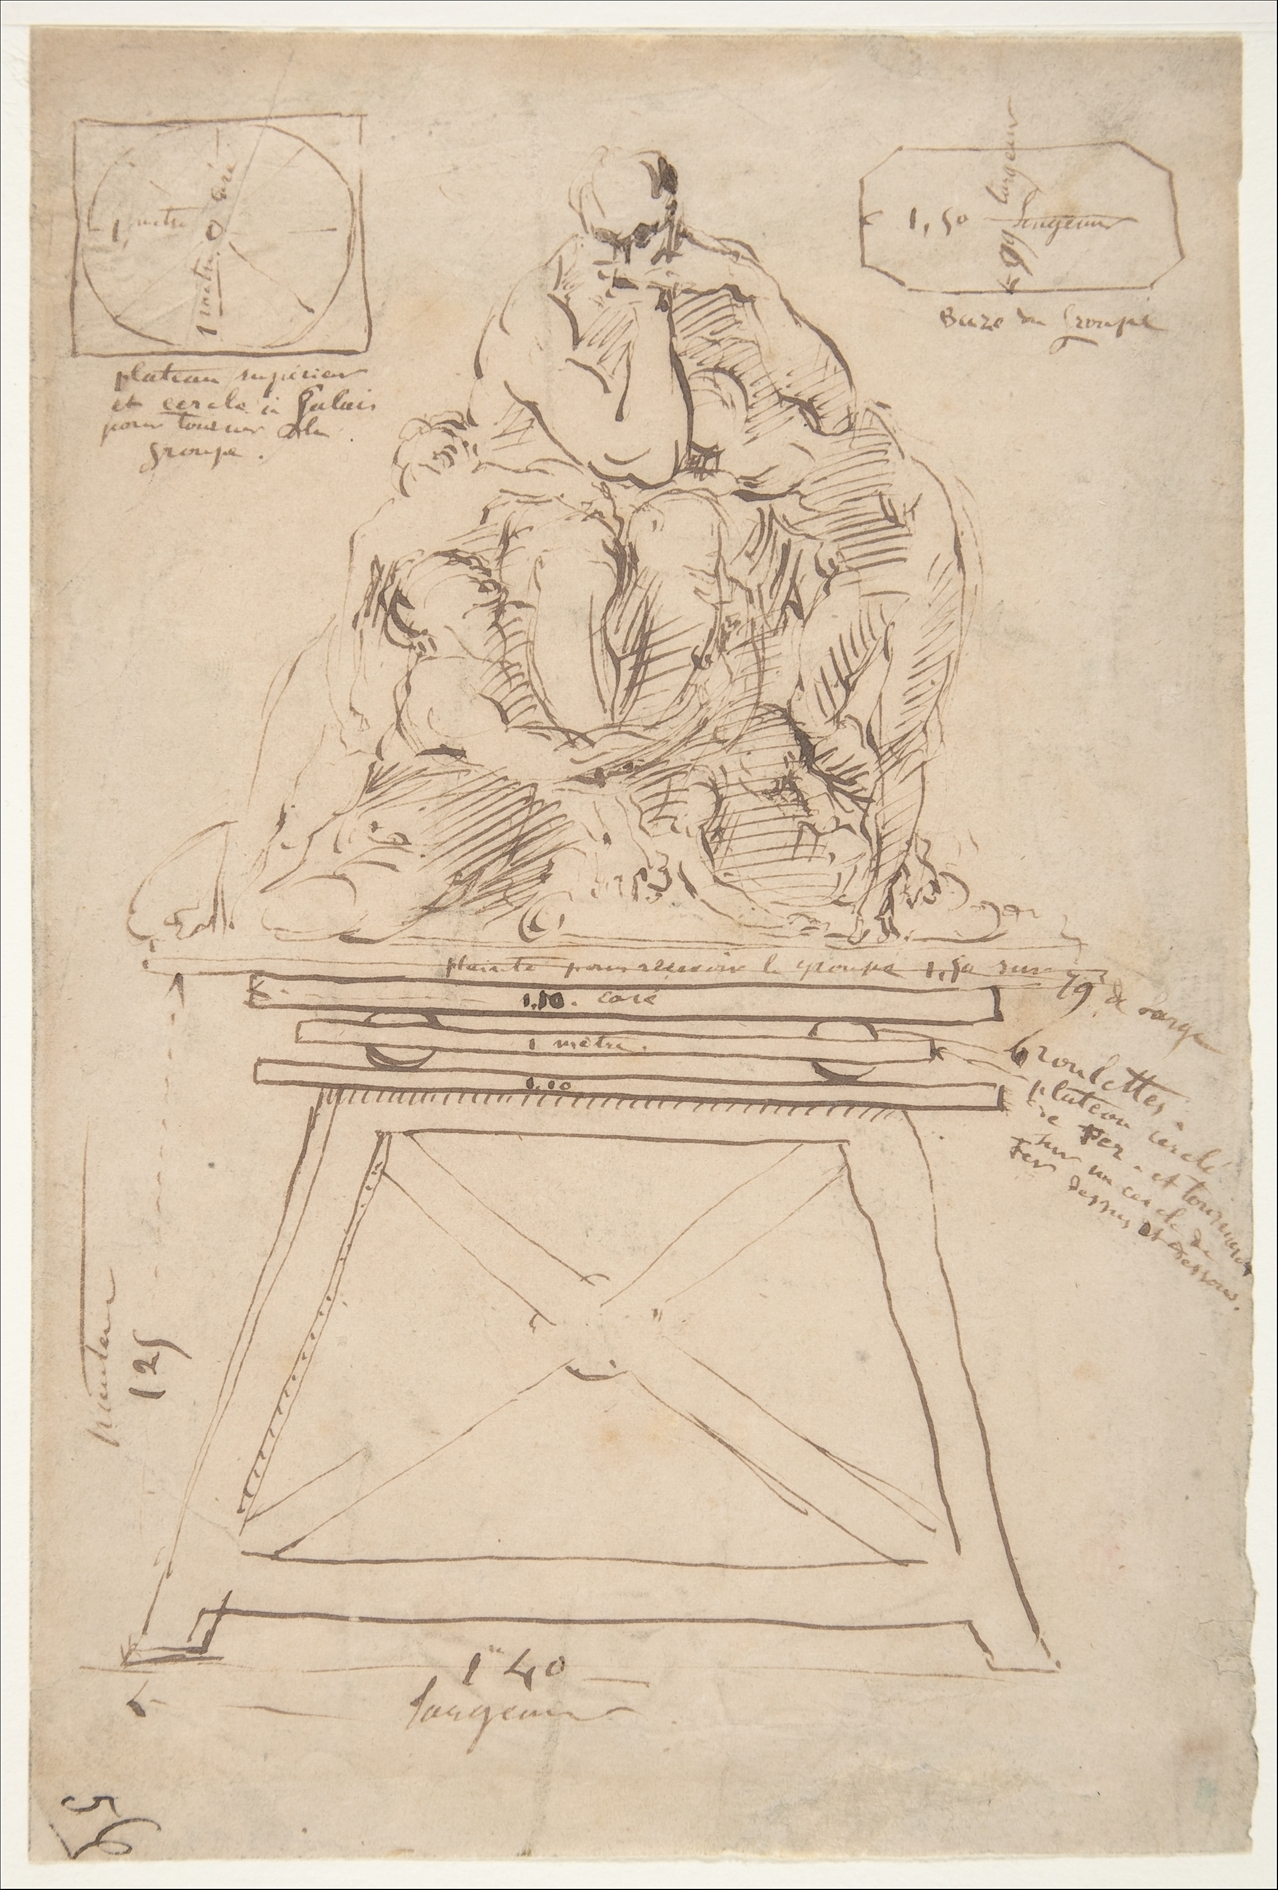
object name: drawing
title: Study for the modeling stand of the Ugolino group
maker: jean-baptiste carpeaux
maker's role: artist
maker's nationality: french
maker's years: 1827-1875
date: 1801-1900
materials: ink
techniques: pen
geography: france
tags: sculpture,men